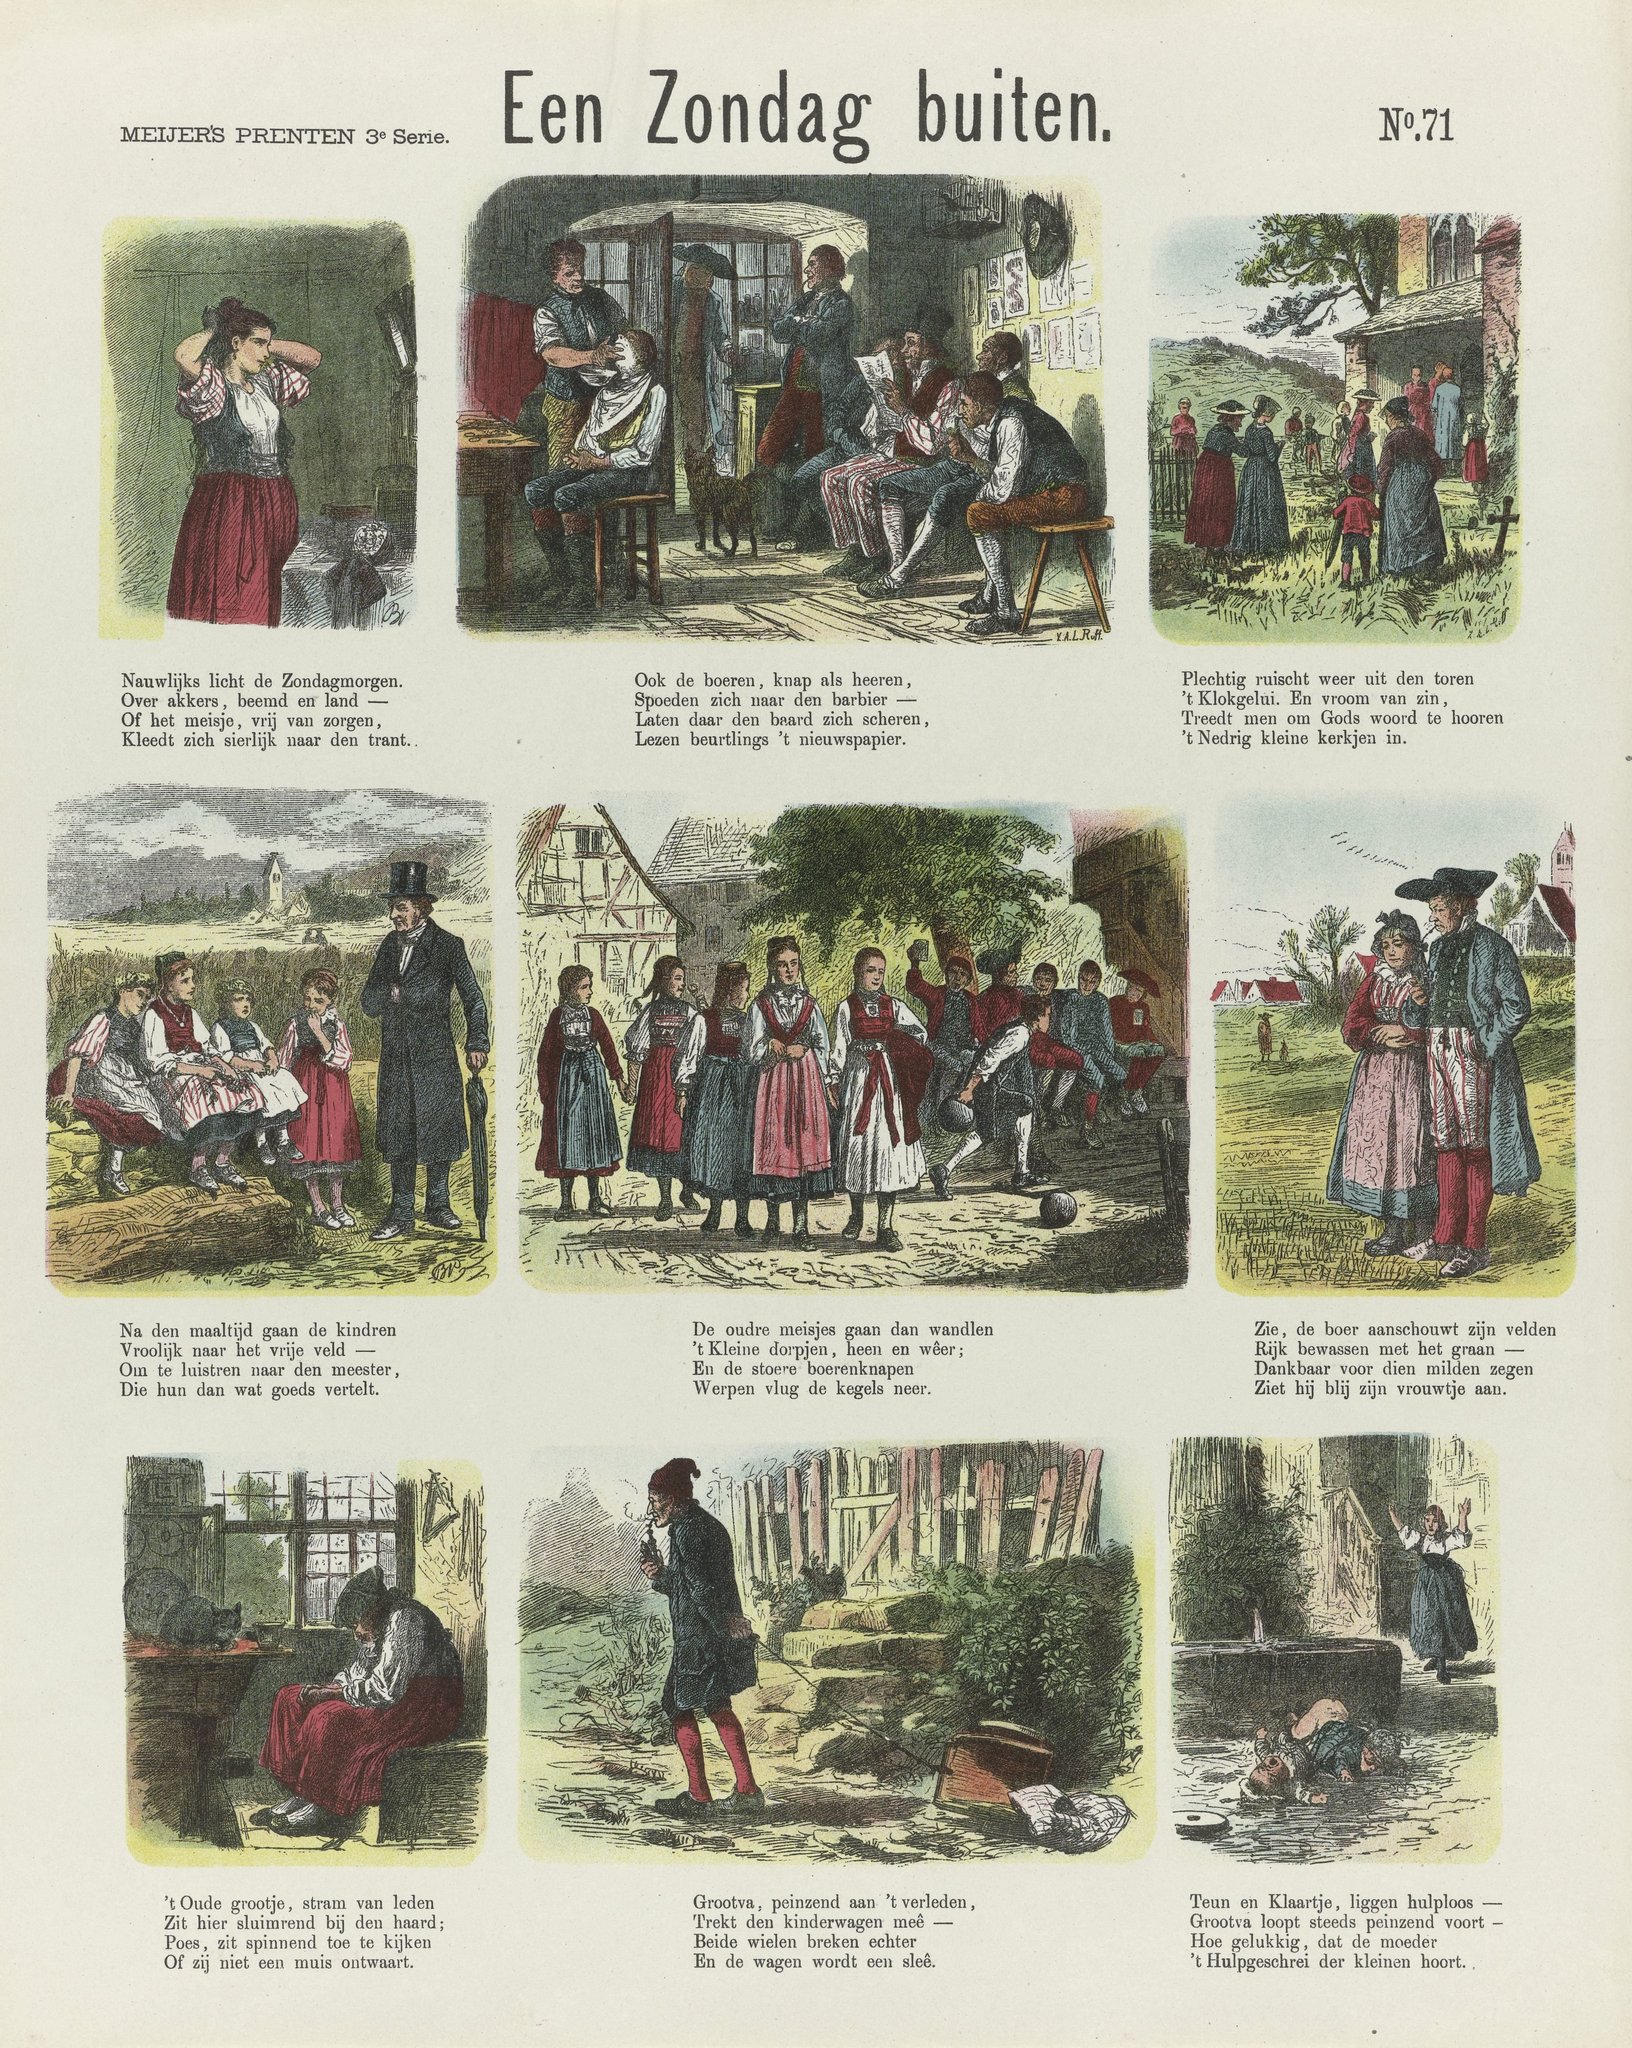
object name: print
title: Meijer's prenten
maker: Anonymous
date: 1878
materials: paper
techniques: lithograph, letterpress printing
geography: amsterdam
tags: rural life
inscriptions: collector's mark: Lugt 2760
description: Blad met 9 voorstellingen van het plattelandsleven. Onder elke voorstelling een vierregelig vers. Genummerd rechtsboven: No. 71.